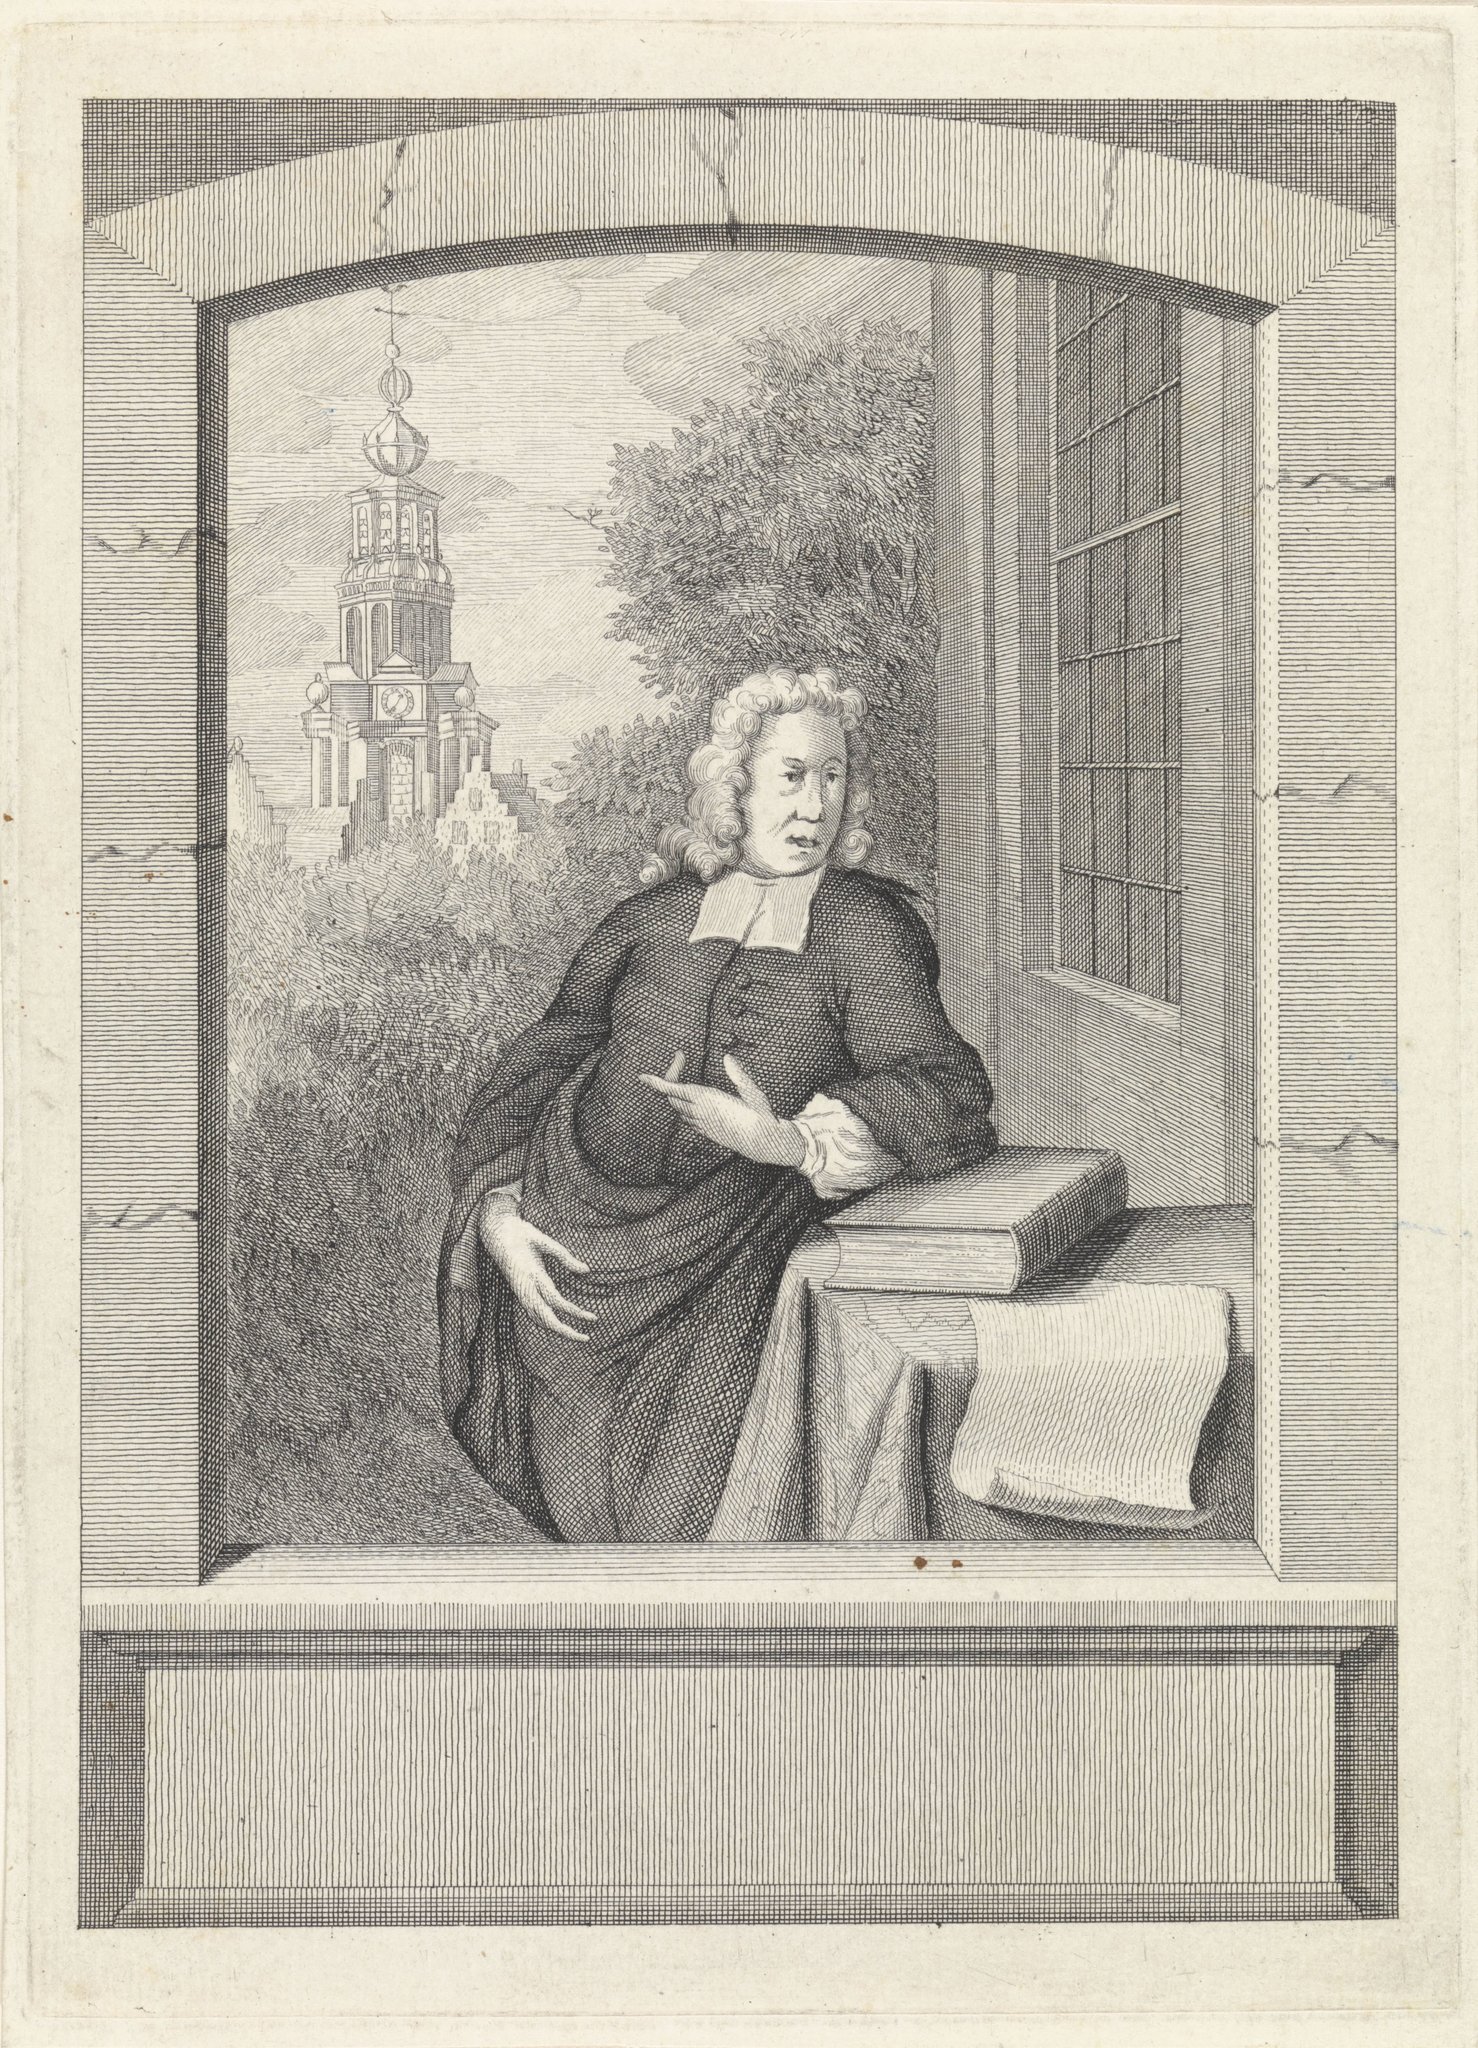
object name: print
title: Portret van predikant Jacobus Covijn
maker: barent de bakker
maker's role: print maker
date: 1762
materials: paper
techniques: engraving, etching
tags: functionaries and dignitaries (with name) ~ episcopal protestant churches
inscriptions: collector's mark: Lugt 2228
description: Portret van predikant Jacobus Covijn met op achtergrond de toren van de Westerkerk te Amsterdam.